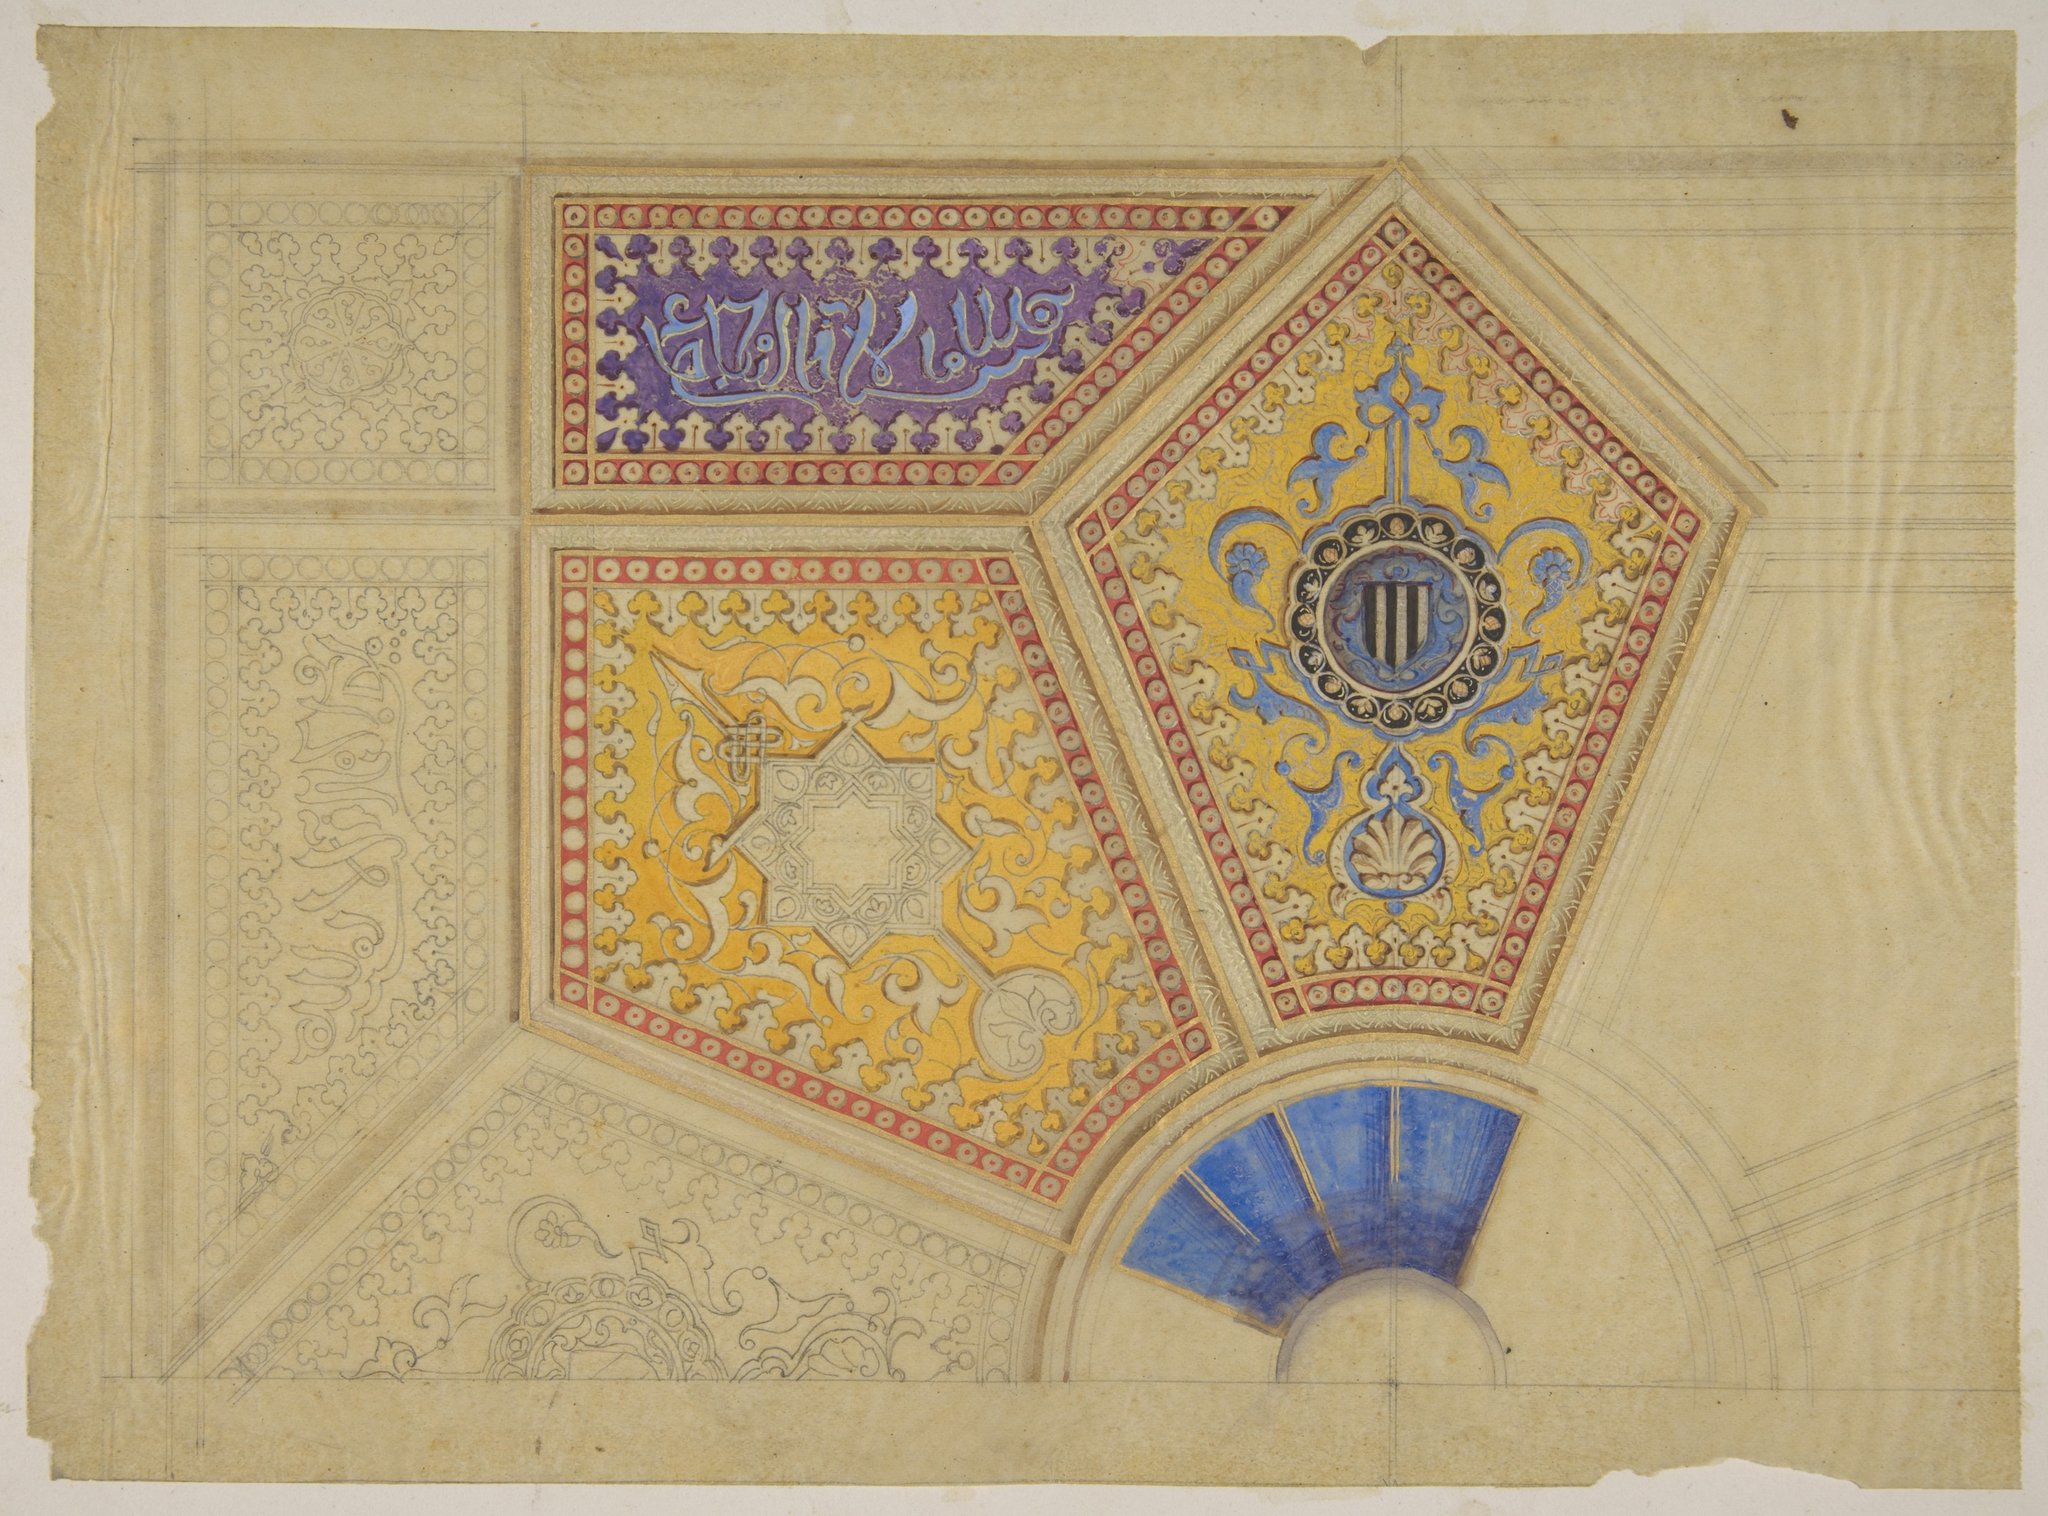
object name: drawing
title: Design for the painted decoration of a coffered ceiling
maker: jules-edmond-charles lachaise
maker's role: artist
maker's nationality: french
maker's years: 1897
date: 1851-1900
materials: gold paint, gouache, graphite, paper, watercolor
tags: ceilings